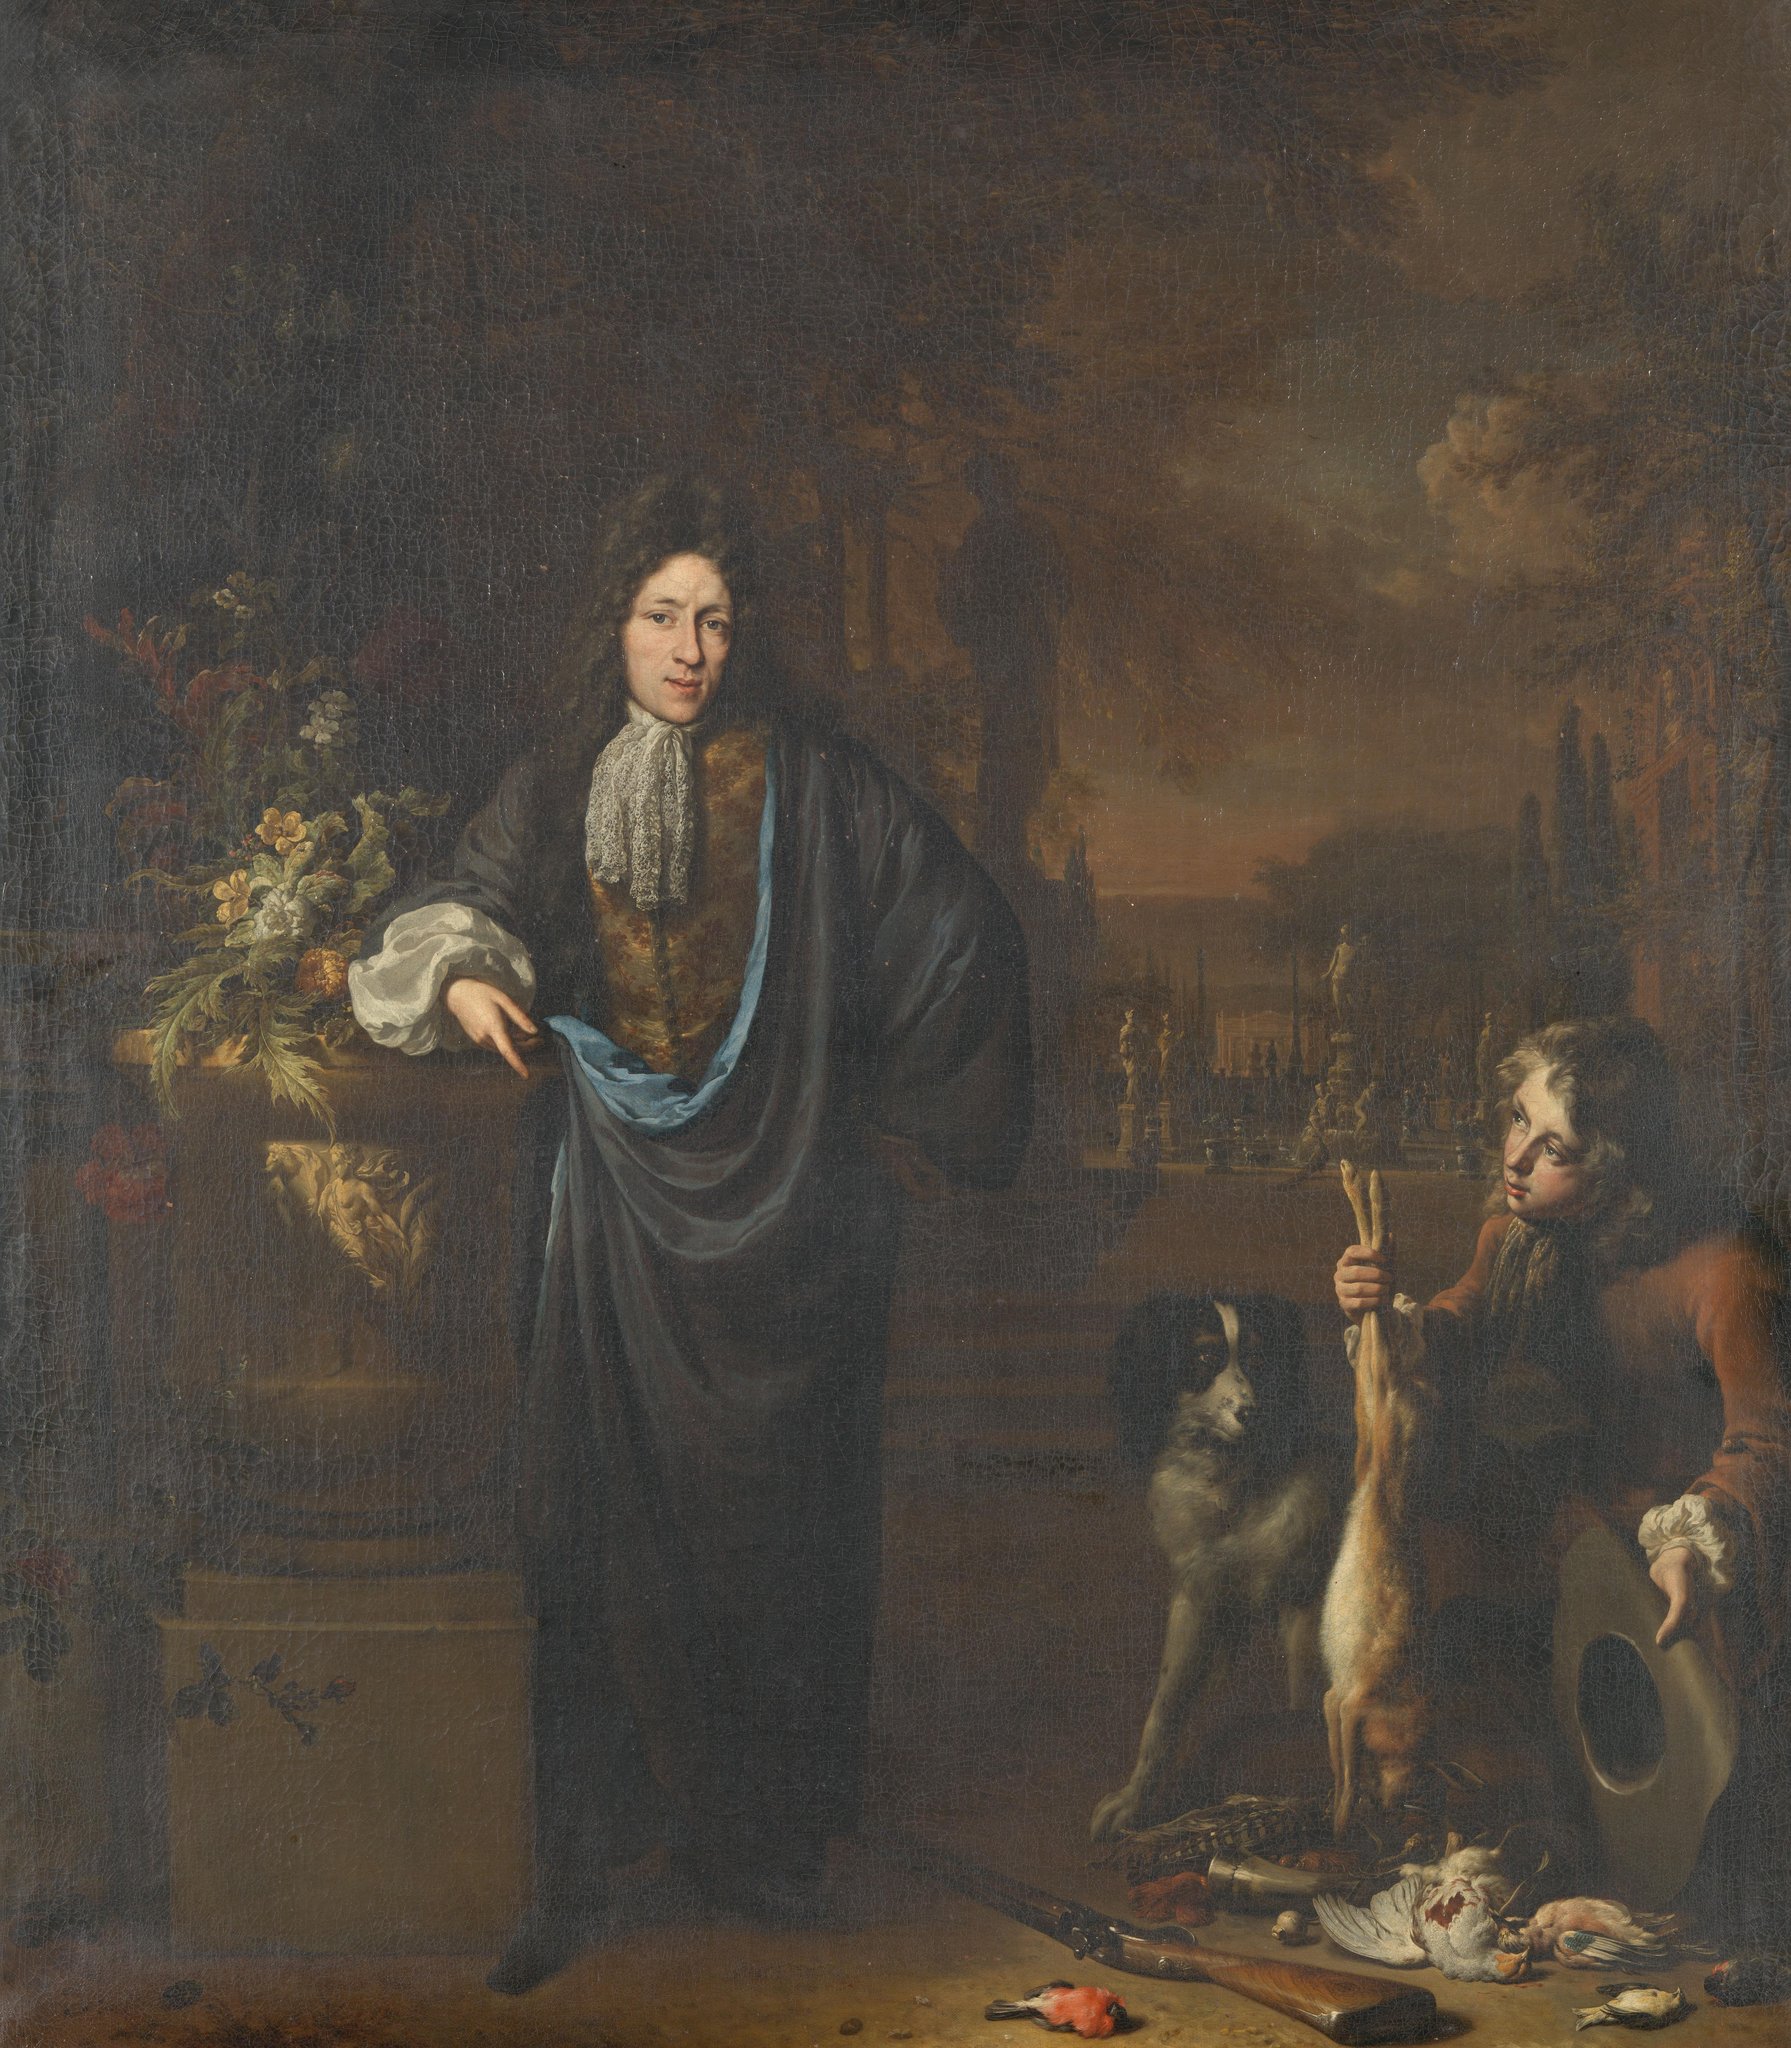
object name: painting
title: Portrait of Silvester van Tongeren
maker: jan weenix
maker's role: draughtsman, painter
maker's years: 1640-1719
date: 1680-1719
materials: oil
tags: historical persons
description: Portret van Silvester van Tongeren. Pendant van SK-A-4959.